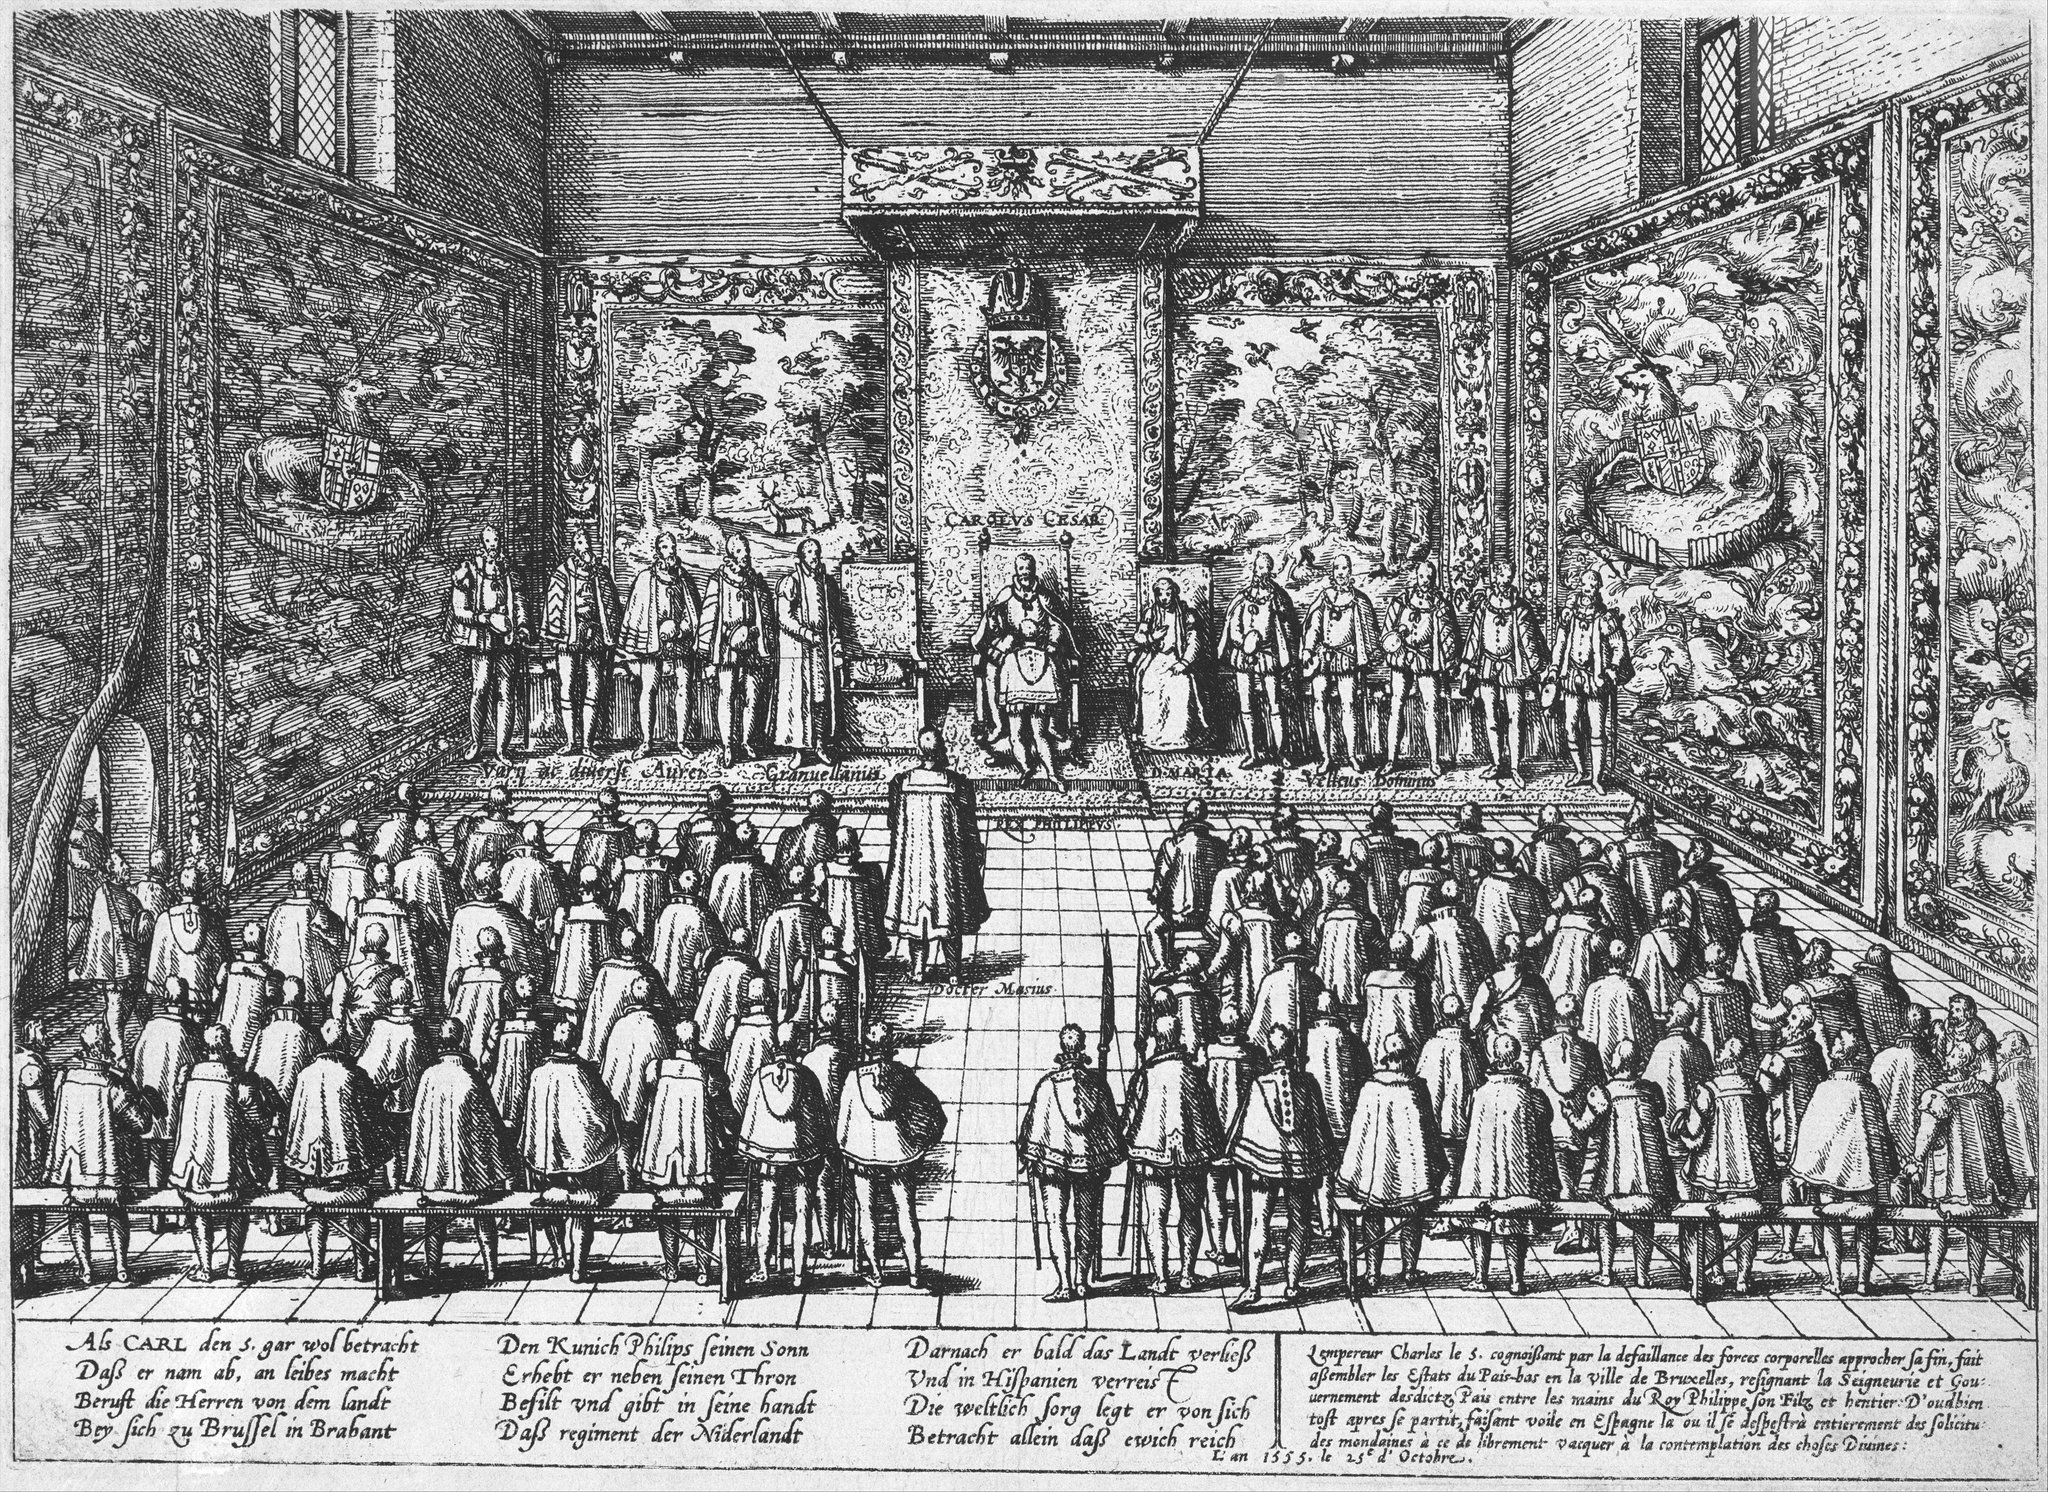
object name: book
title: Events in the History of the Netherlands, France, Germany and England between 1535 and 1608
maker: frans hogenberg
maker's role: artist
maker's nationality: netherlandish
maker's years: 1540-1590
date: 1501-1600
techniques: engraving, etching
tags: crowd